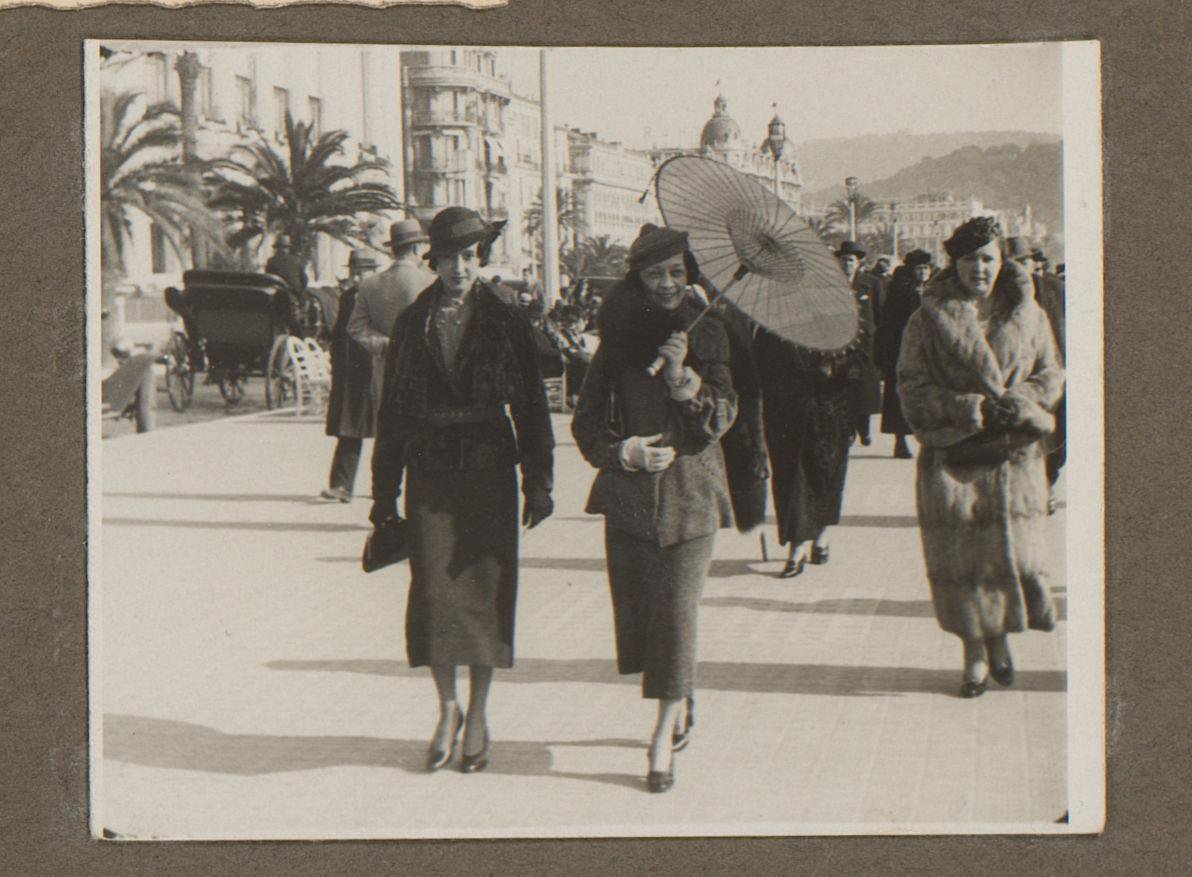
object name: photograph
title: Portret van Dootje met een baret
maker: Anonymous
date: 1934-1935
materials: paper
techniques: gelatin silver print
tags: historical persons - bb - woman, head-gear: beret